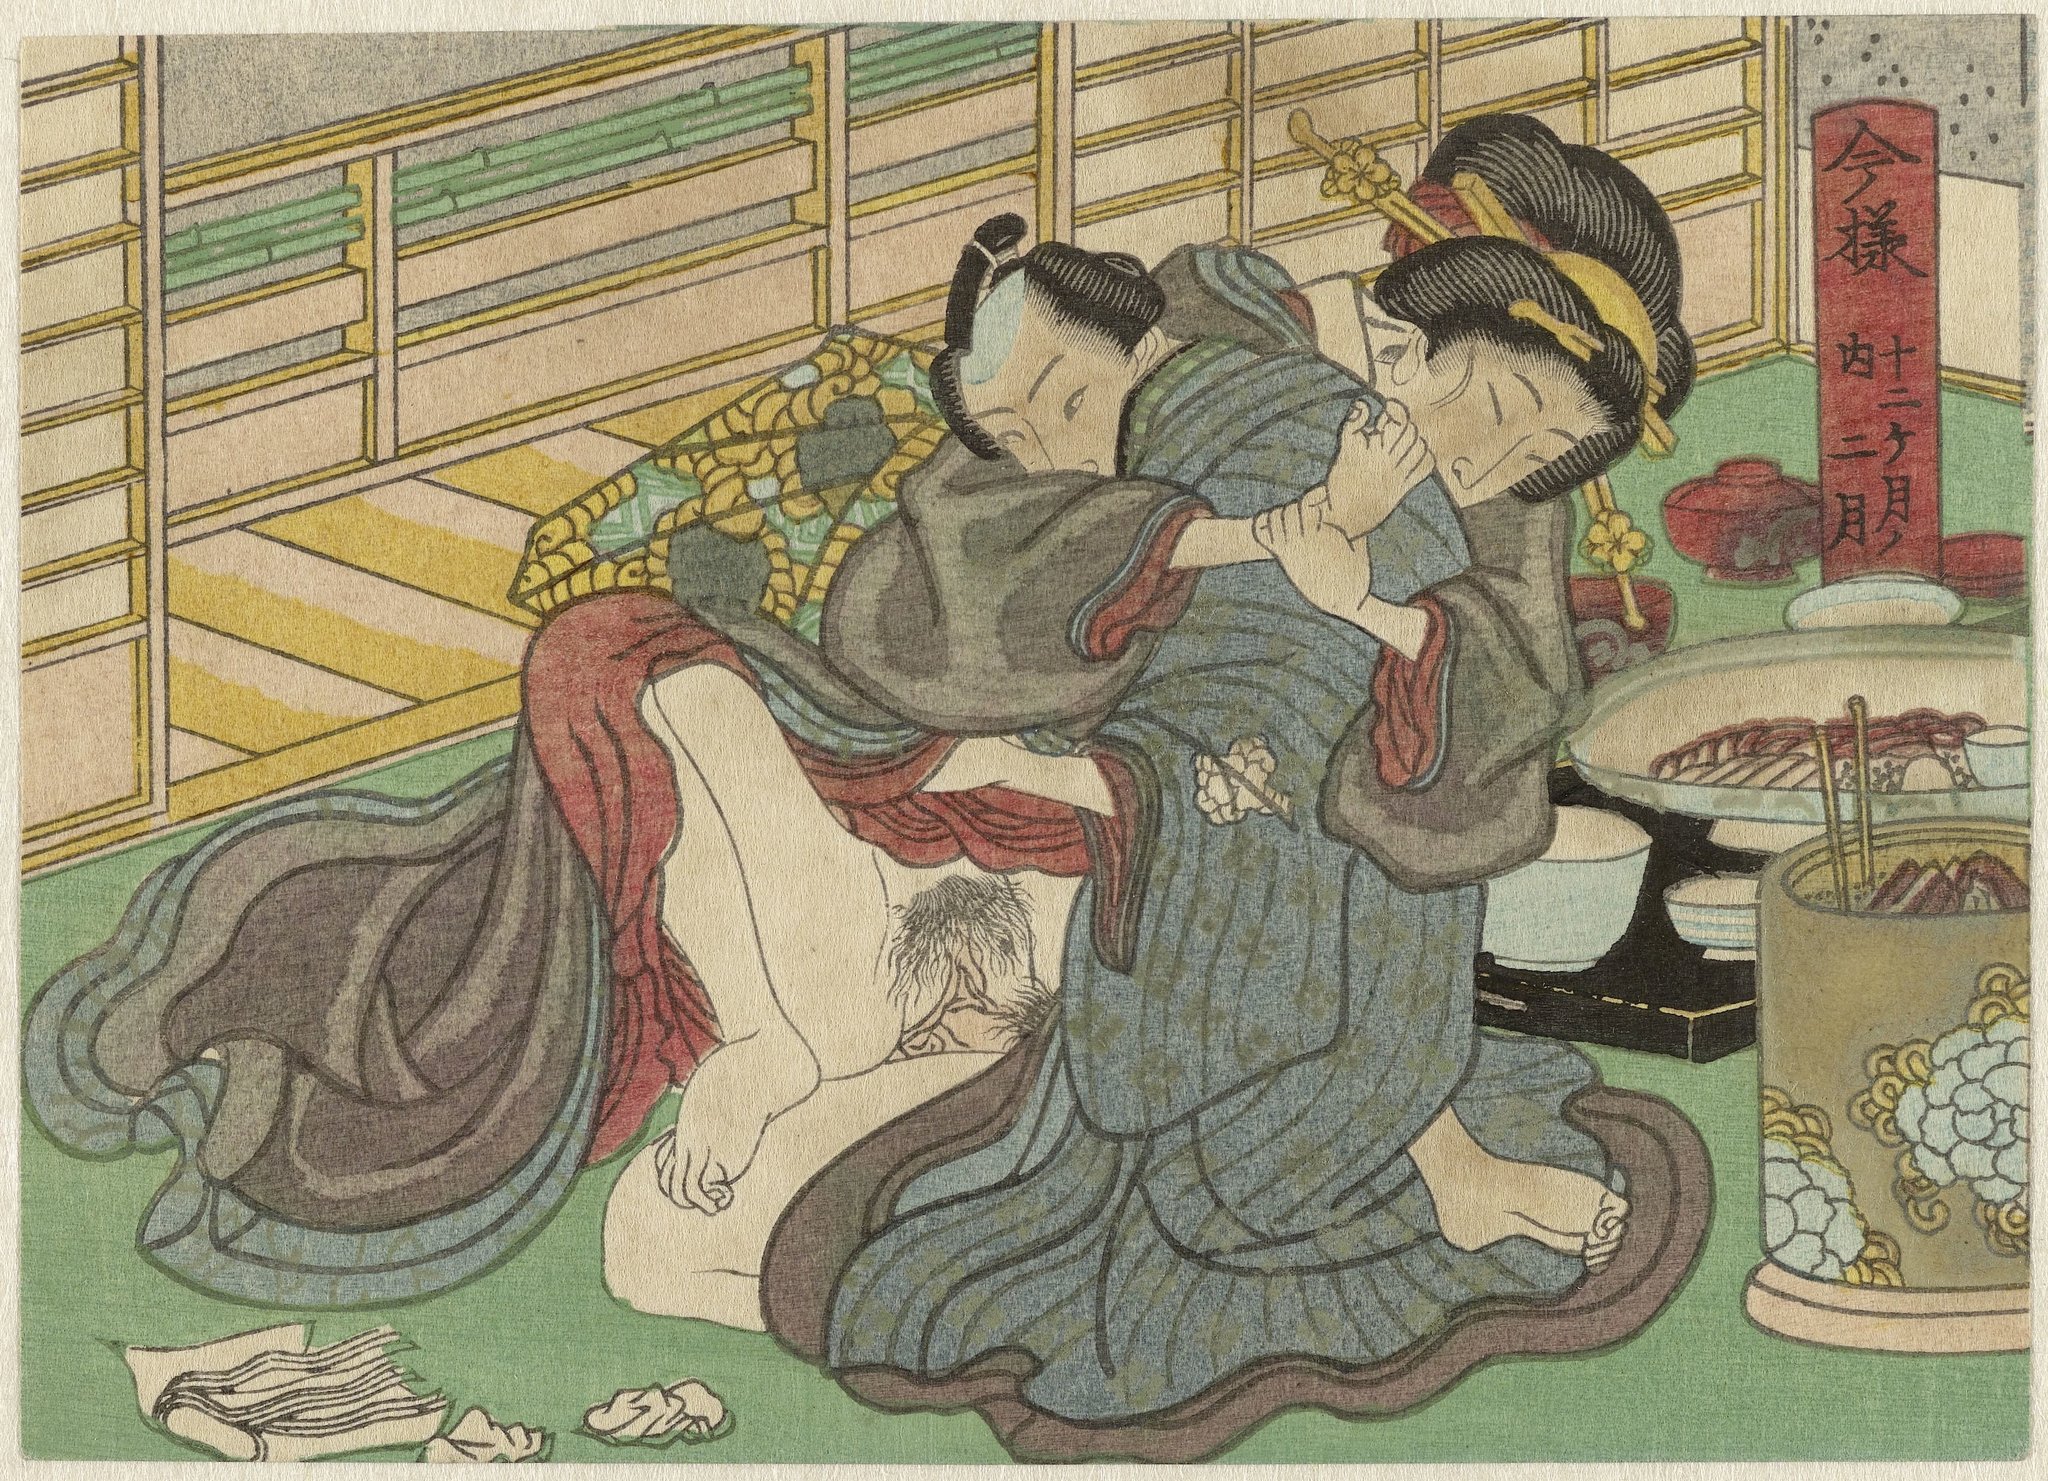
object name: print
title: Imayô jûni kagetsu no uchi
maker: Anonymous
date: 1835-1845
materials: paper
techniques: woodcut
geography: japan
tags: the twelve months of the year represented by concepts other than personifications, human activities, landscapes, or still lifes of flowers and/or fruits, coitus, cohabiting, sexual intercourse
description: Naast de resten van een maaltijd zit een man op zijn hurken. De vrouw zit op hem en klampt zich aan hem vast in een omhelzing. Hun geslachtsdelen zijn zichtbaar tussen de weggeslagen kimono's.